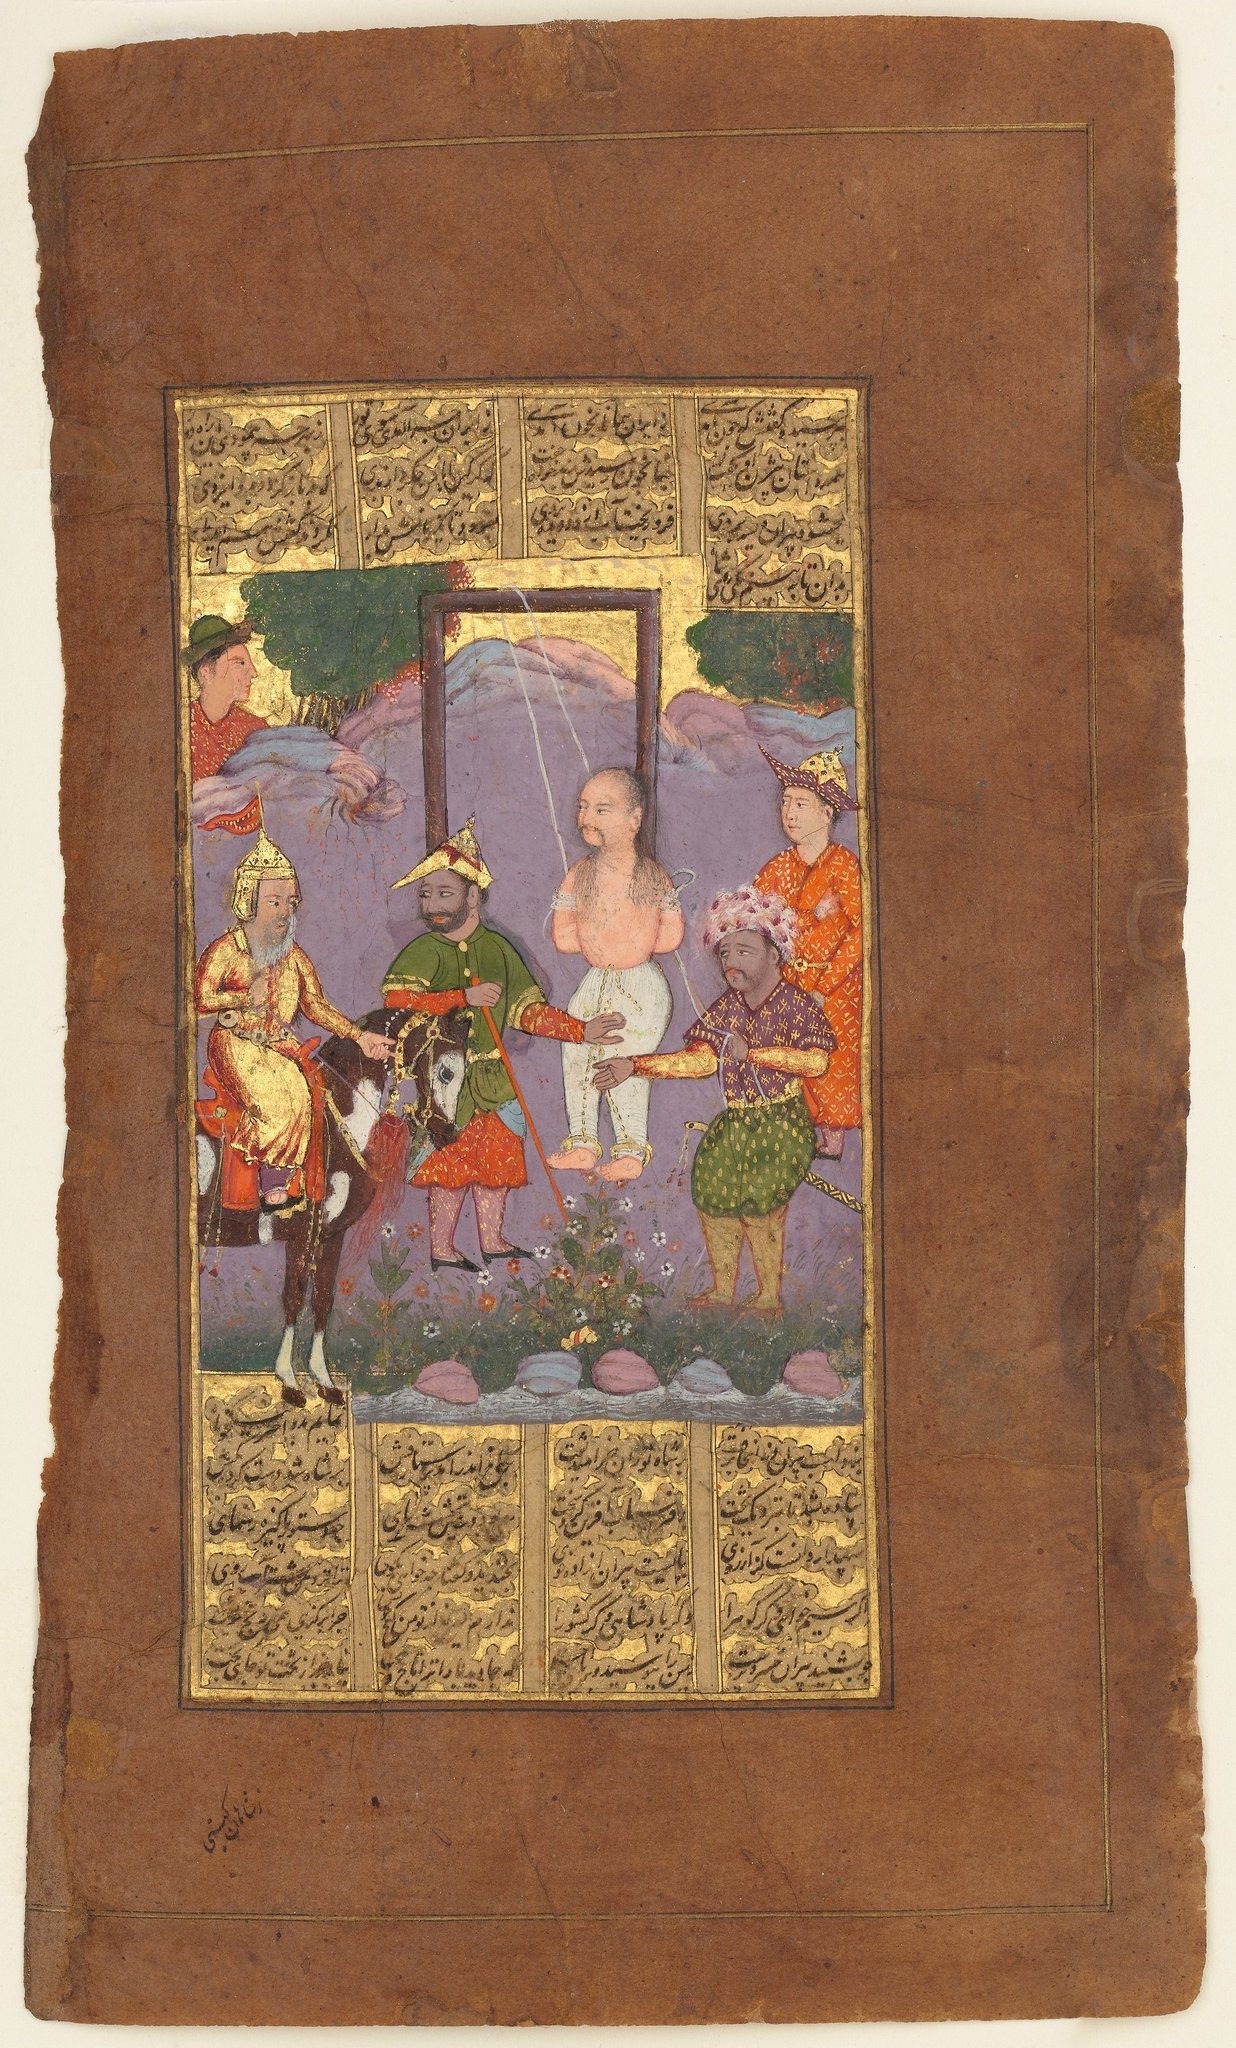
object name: folio from an illustrated manuscript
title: "Rescue of Bizhan by Piran", Folio from a Shahnama (Book of Kings) of Firdausi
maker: abu'l qasim firdausi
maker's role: author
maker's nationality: iranian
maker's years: 935-1020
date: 1610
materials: gold, ink, paper, watercolor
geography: india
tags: men,horses